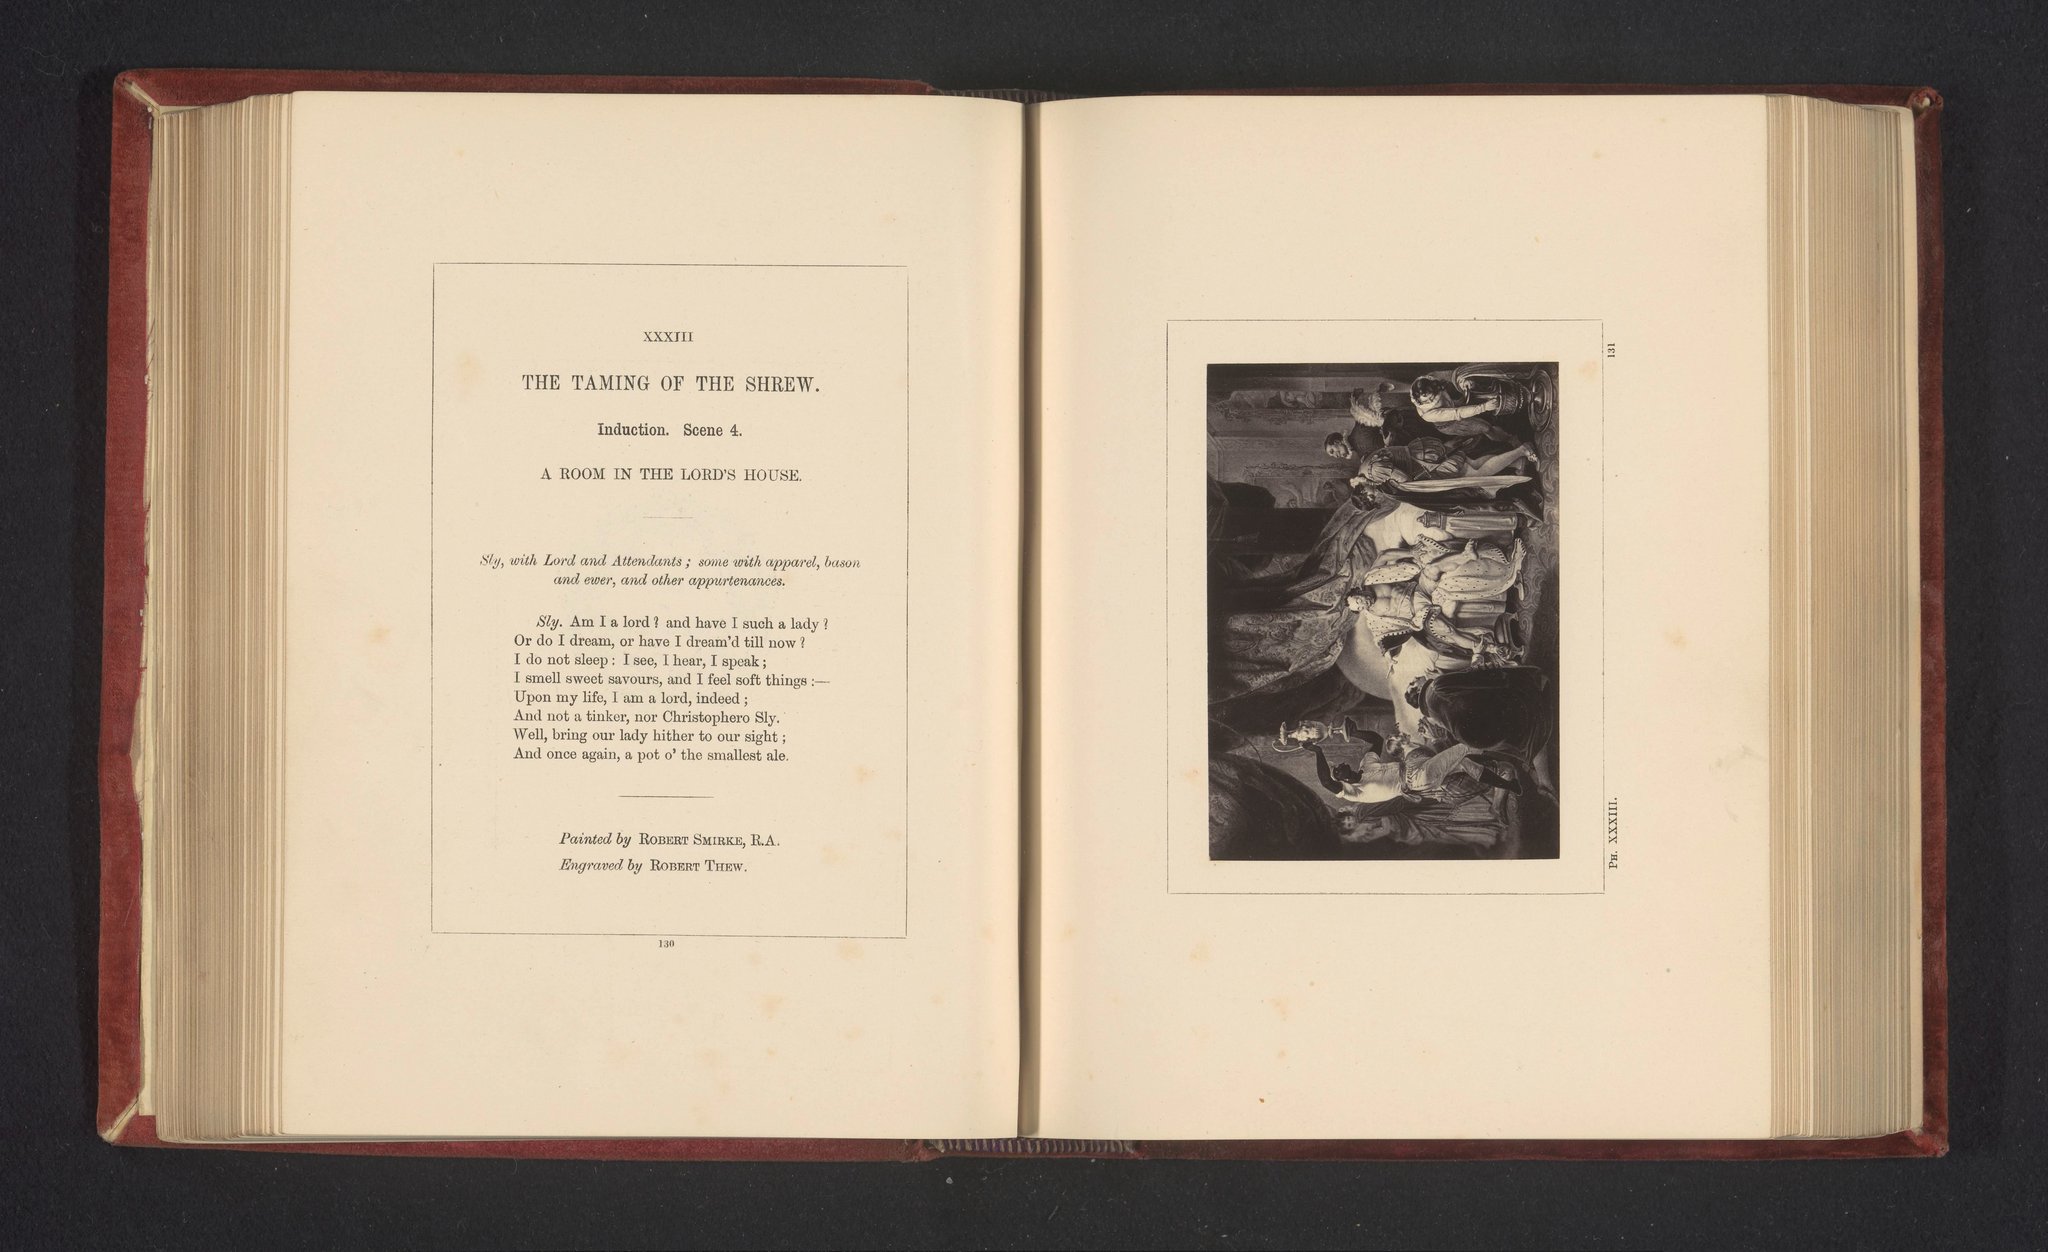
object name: page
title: Fotoreproductie van een prent naar een schilderij door Robert Smirke, voorstellend een scene uit Het temmen van de feeks door William Shakespeare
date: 1854-1864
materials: photographic support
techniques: albumen print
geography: london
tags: specific works of literature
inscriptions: number: ‘Ph. XXXIII. 131’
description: Te zien is de introductie, scene 4 met Sly en bedienden.